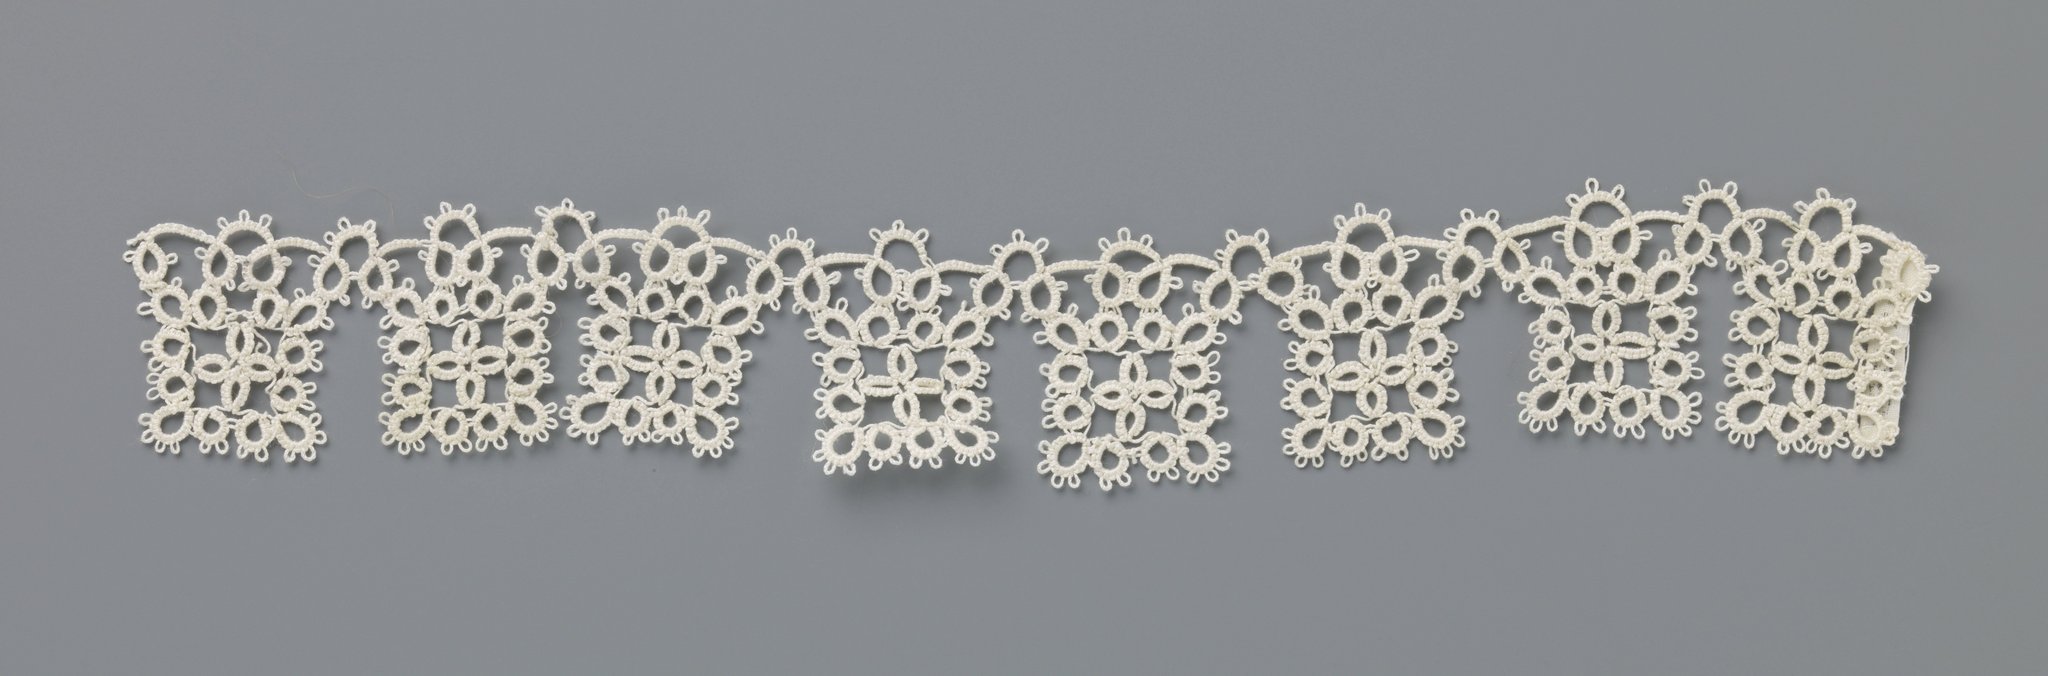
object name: strip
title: Strook geknoopte kant met losse vierkante schulpen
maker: marie waldeck-reiss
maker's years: 1870-1942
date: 1900-1939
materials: linen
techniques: tatting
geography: amsterdam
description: Strook naturelkleurige geknoopte kant: frivolité. Aan een smalle lijn met lussen hangen losse vierkante schulpen met een bloempje gemaakt met vier lussen in het centrum en een rij enkele lussen als lijst, afgewerkt met picots.